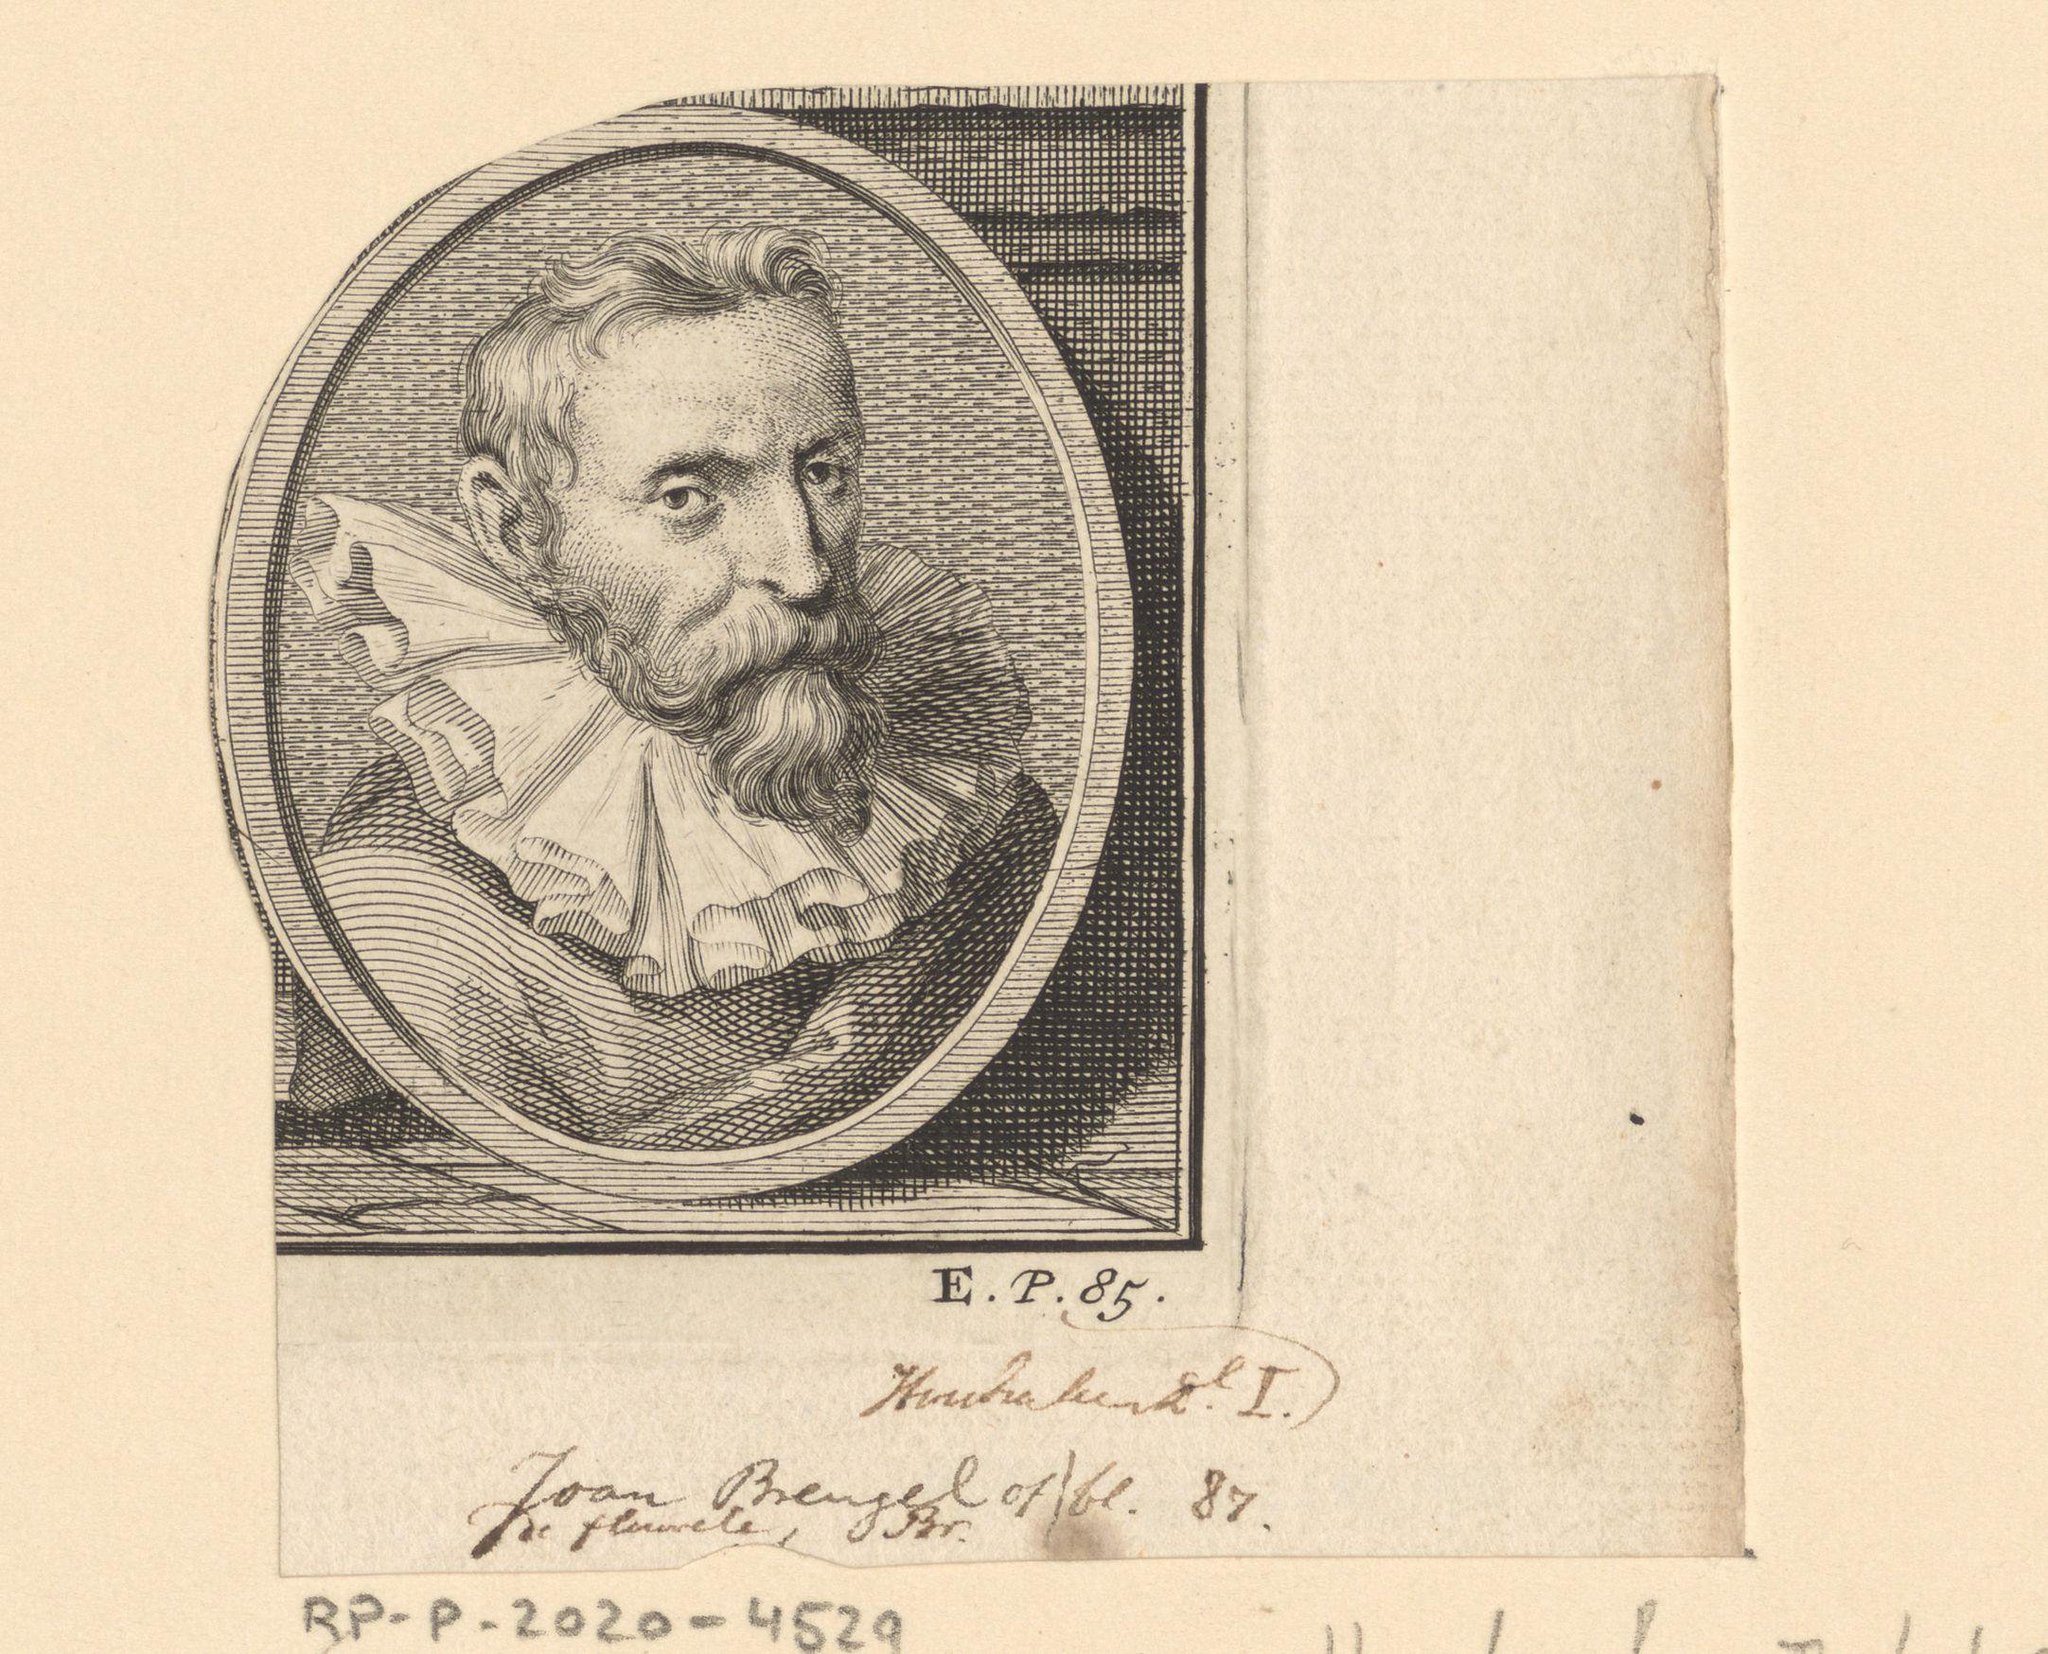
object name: book illustration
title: Portret van Jan Brueghel (I)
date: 1718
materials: paper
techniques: engraving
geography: amsterdam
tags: brussels, antwerp, painter, print maker, draughtsman, jan brueghel (i), historical persons, portrait, self-portrait of artist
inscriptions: inscription: ‘Houbraken dl I/ Joan Breugel[...]’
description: Prent uit: Houbraken, Arnold. De groote schouburgh der Nederlantsche konstschilders en schilderessen (...). Amsterdam: Arnold Houbraken, 1718, dl. 1.